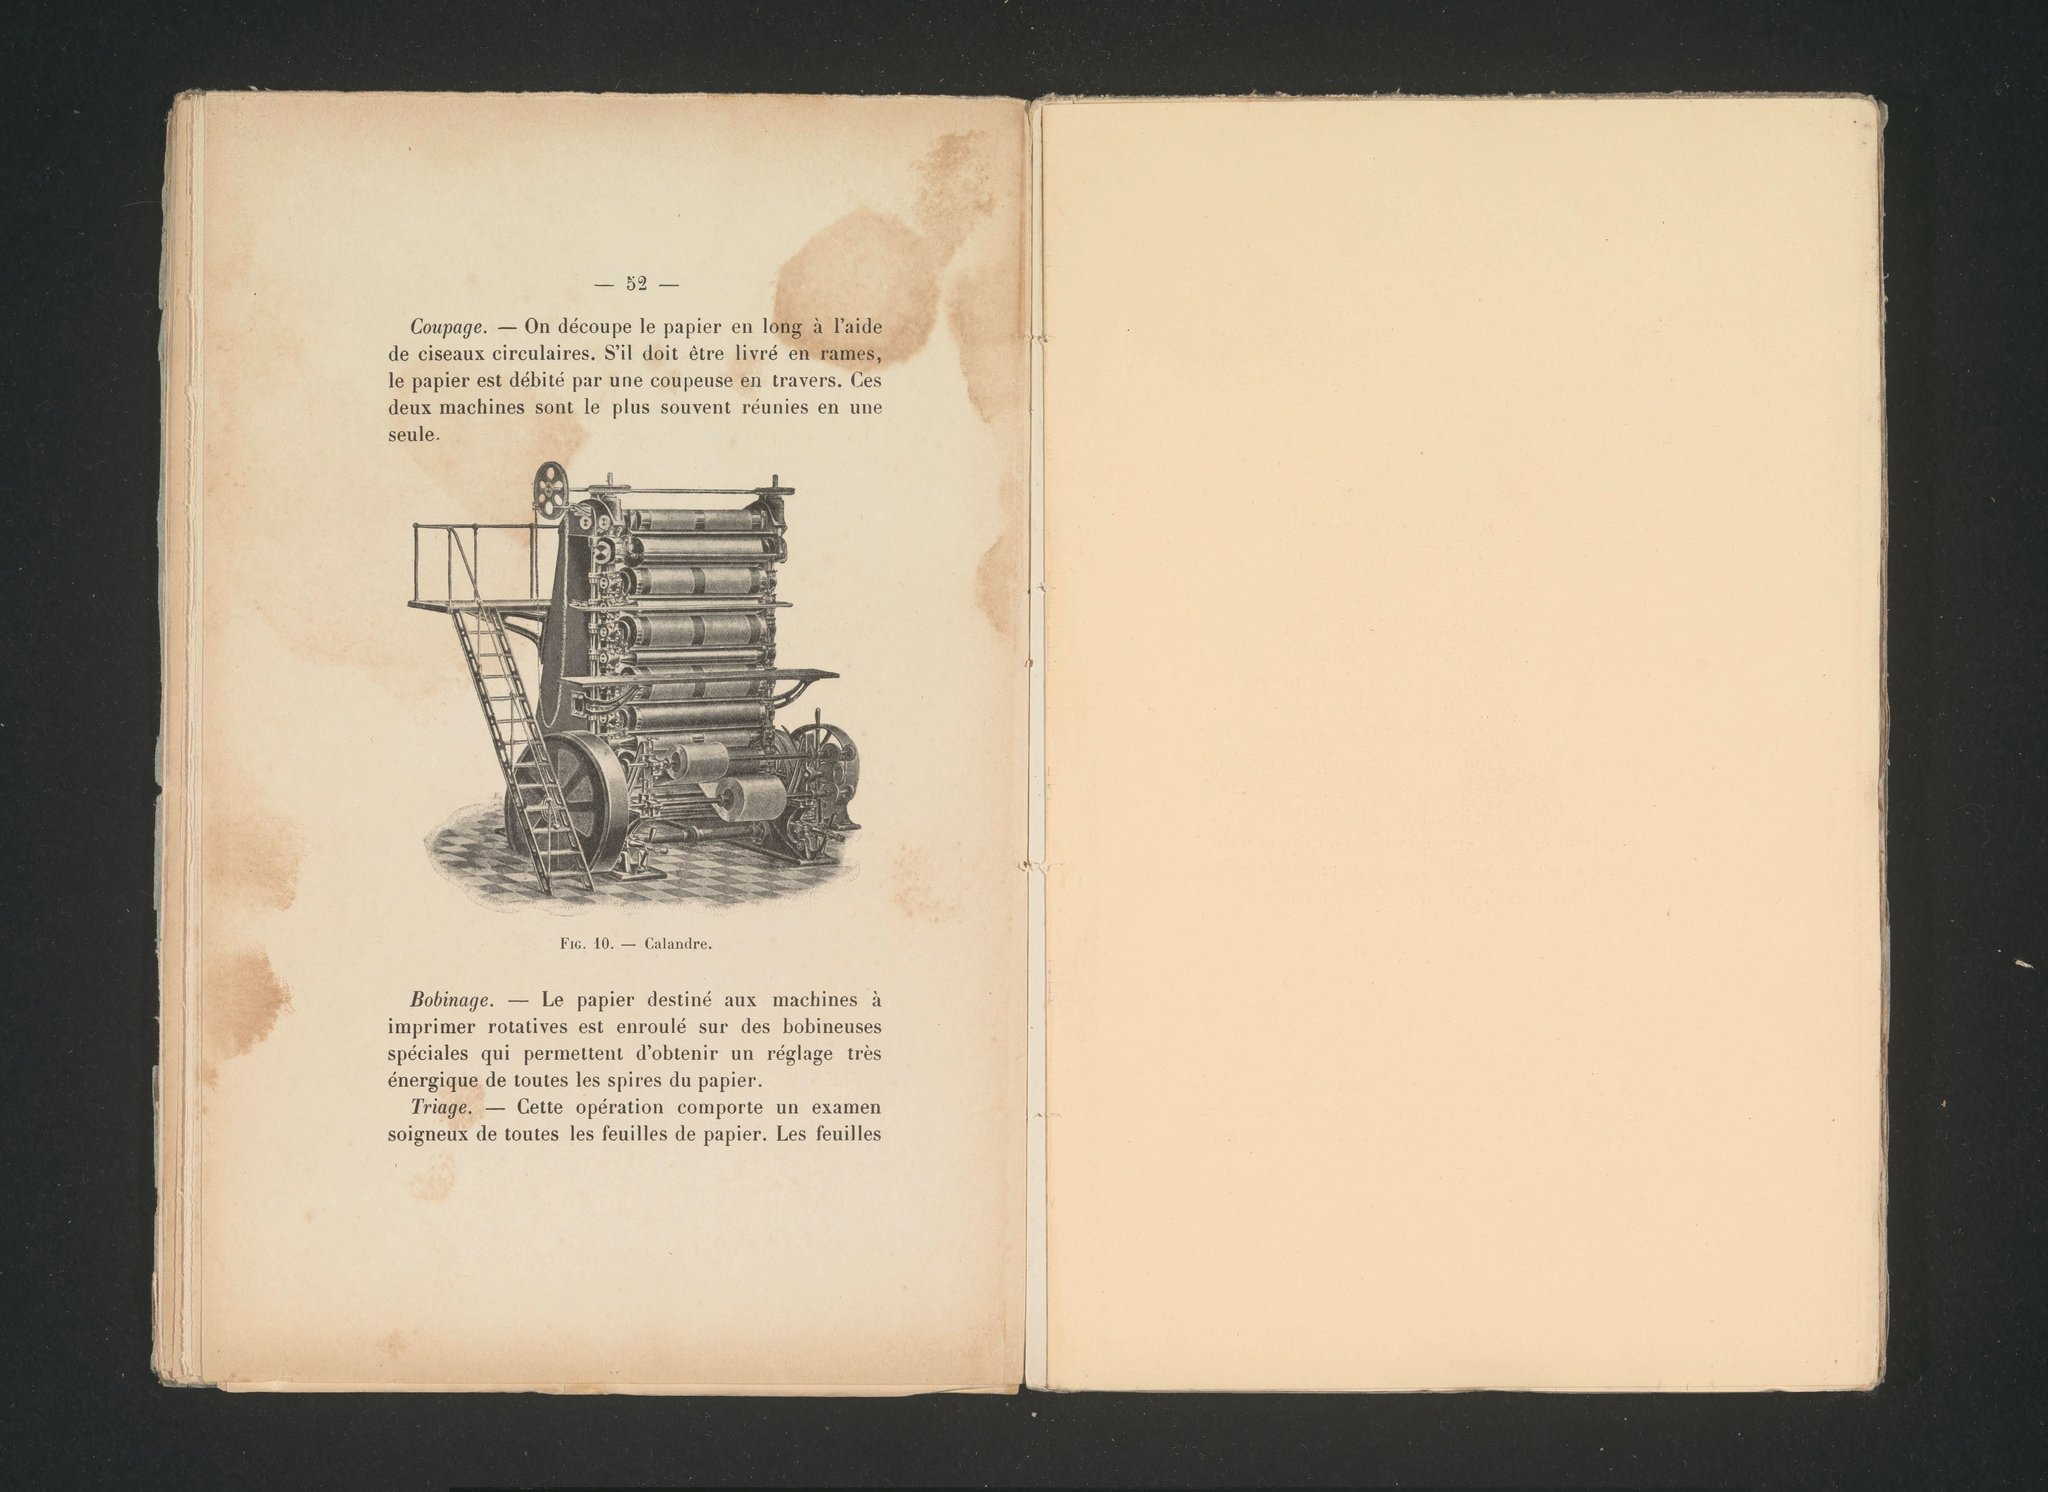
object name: photomechanical print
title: Reproductie van een ontwerp van een machine om papier glad te maken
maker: Anonymous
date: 1901-1906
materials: paper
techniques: autotype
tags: machine driven by electricity, paper (writing material)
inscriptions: inscription: ‘Fig. 10. - Calandre.’